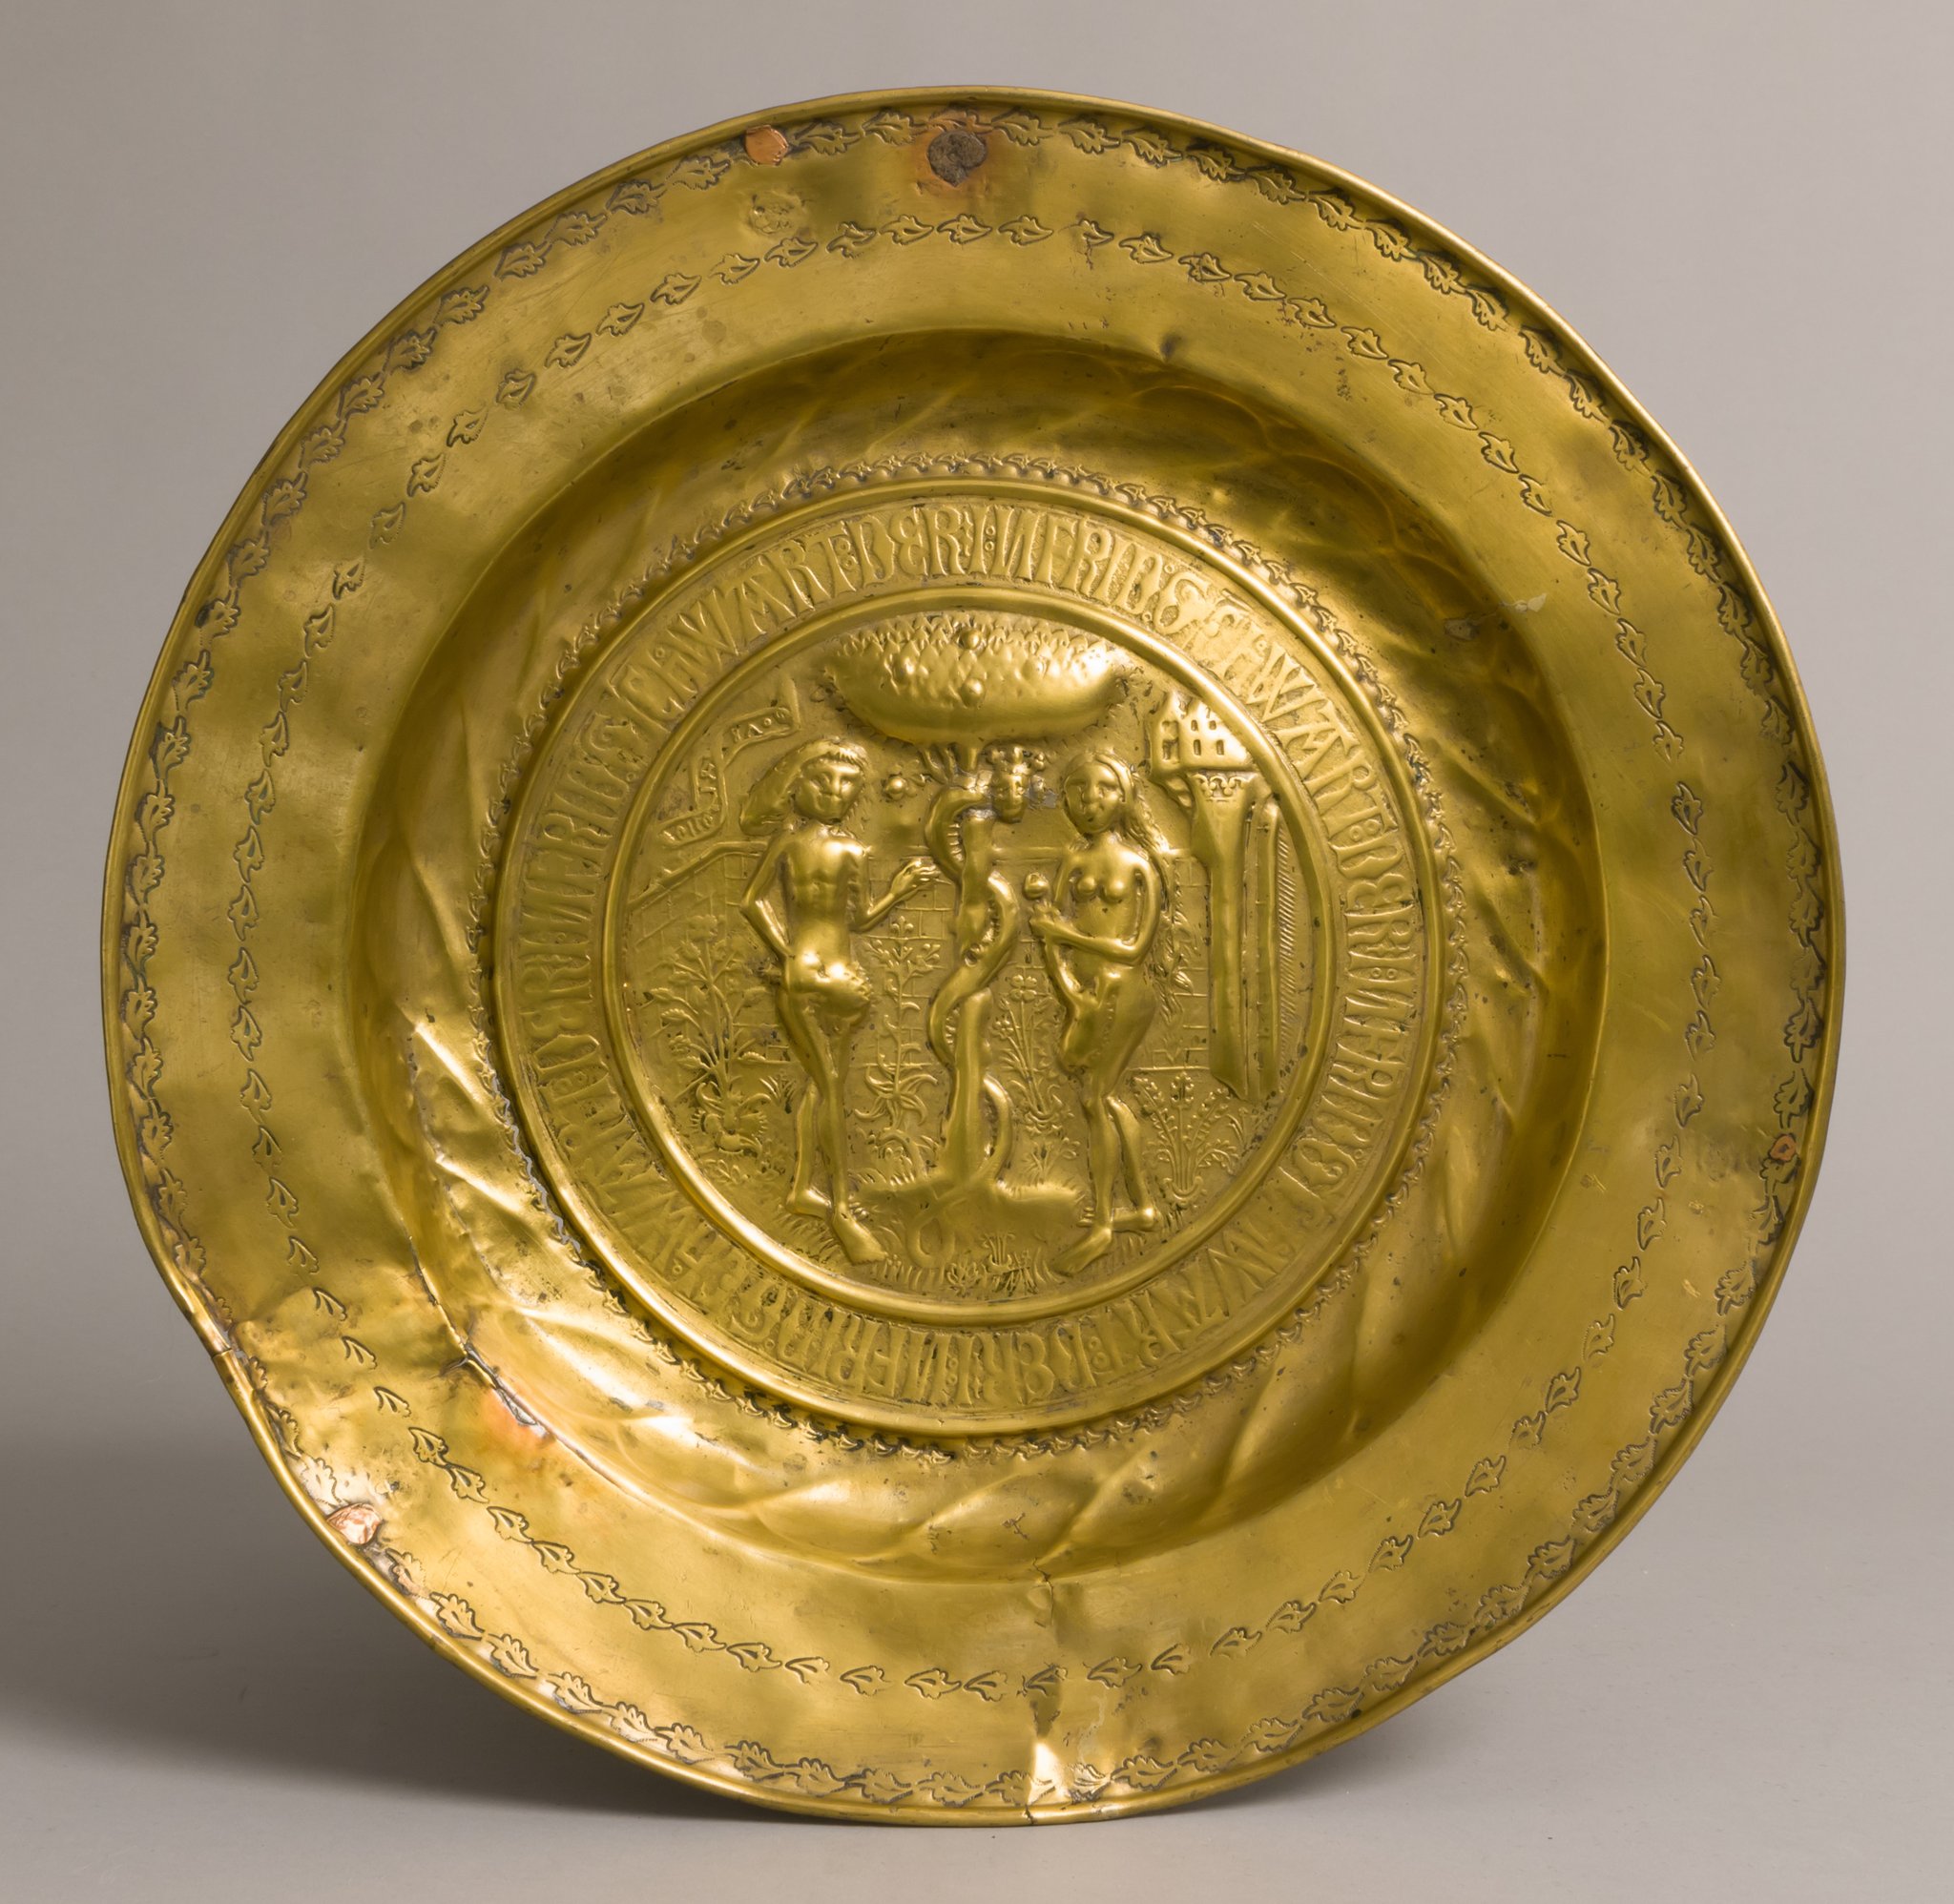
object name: dish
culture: german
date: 1501-1533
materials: brass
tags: snakes,adam,eve